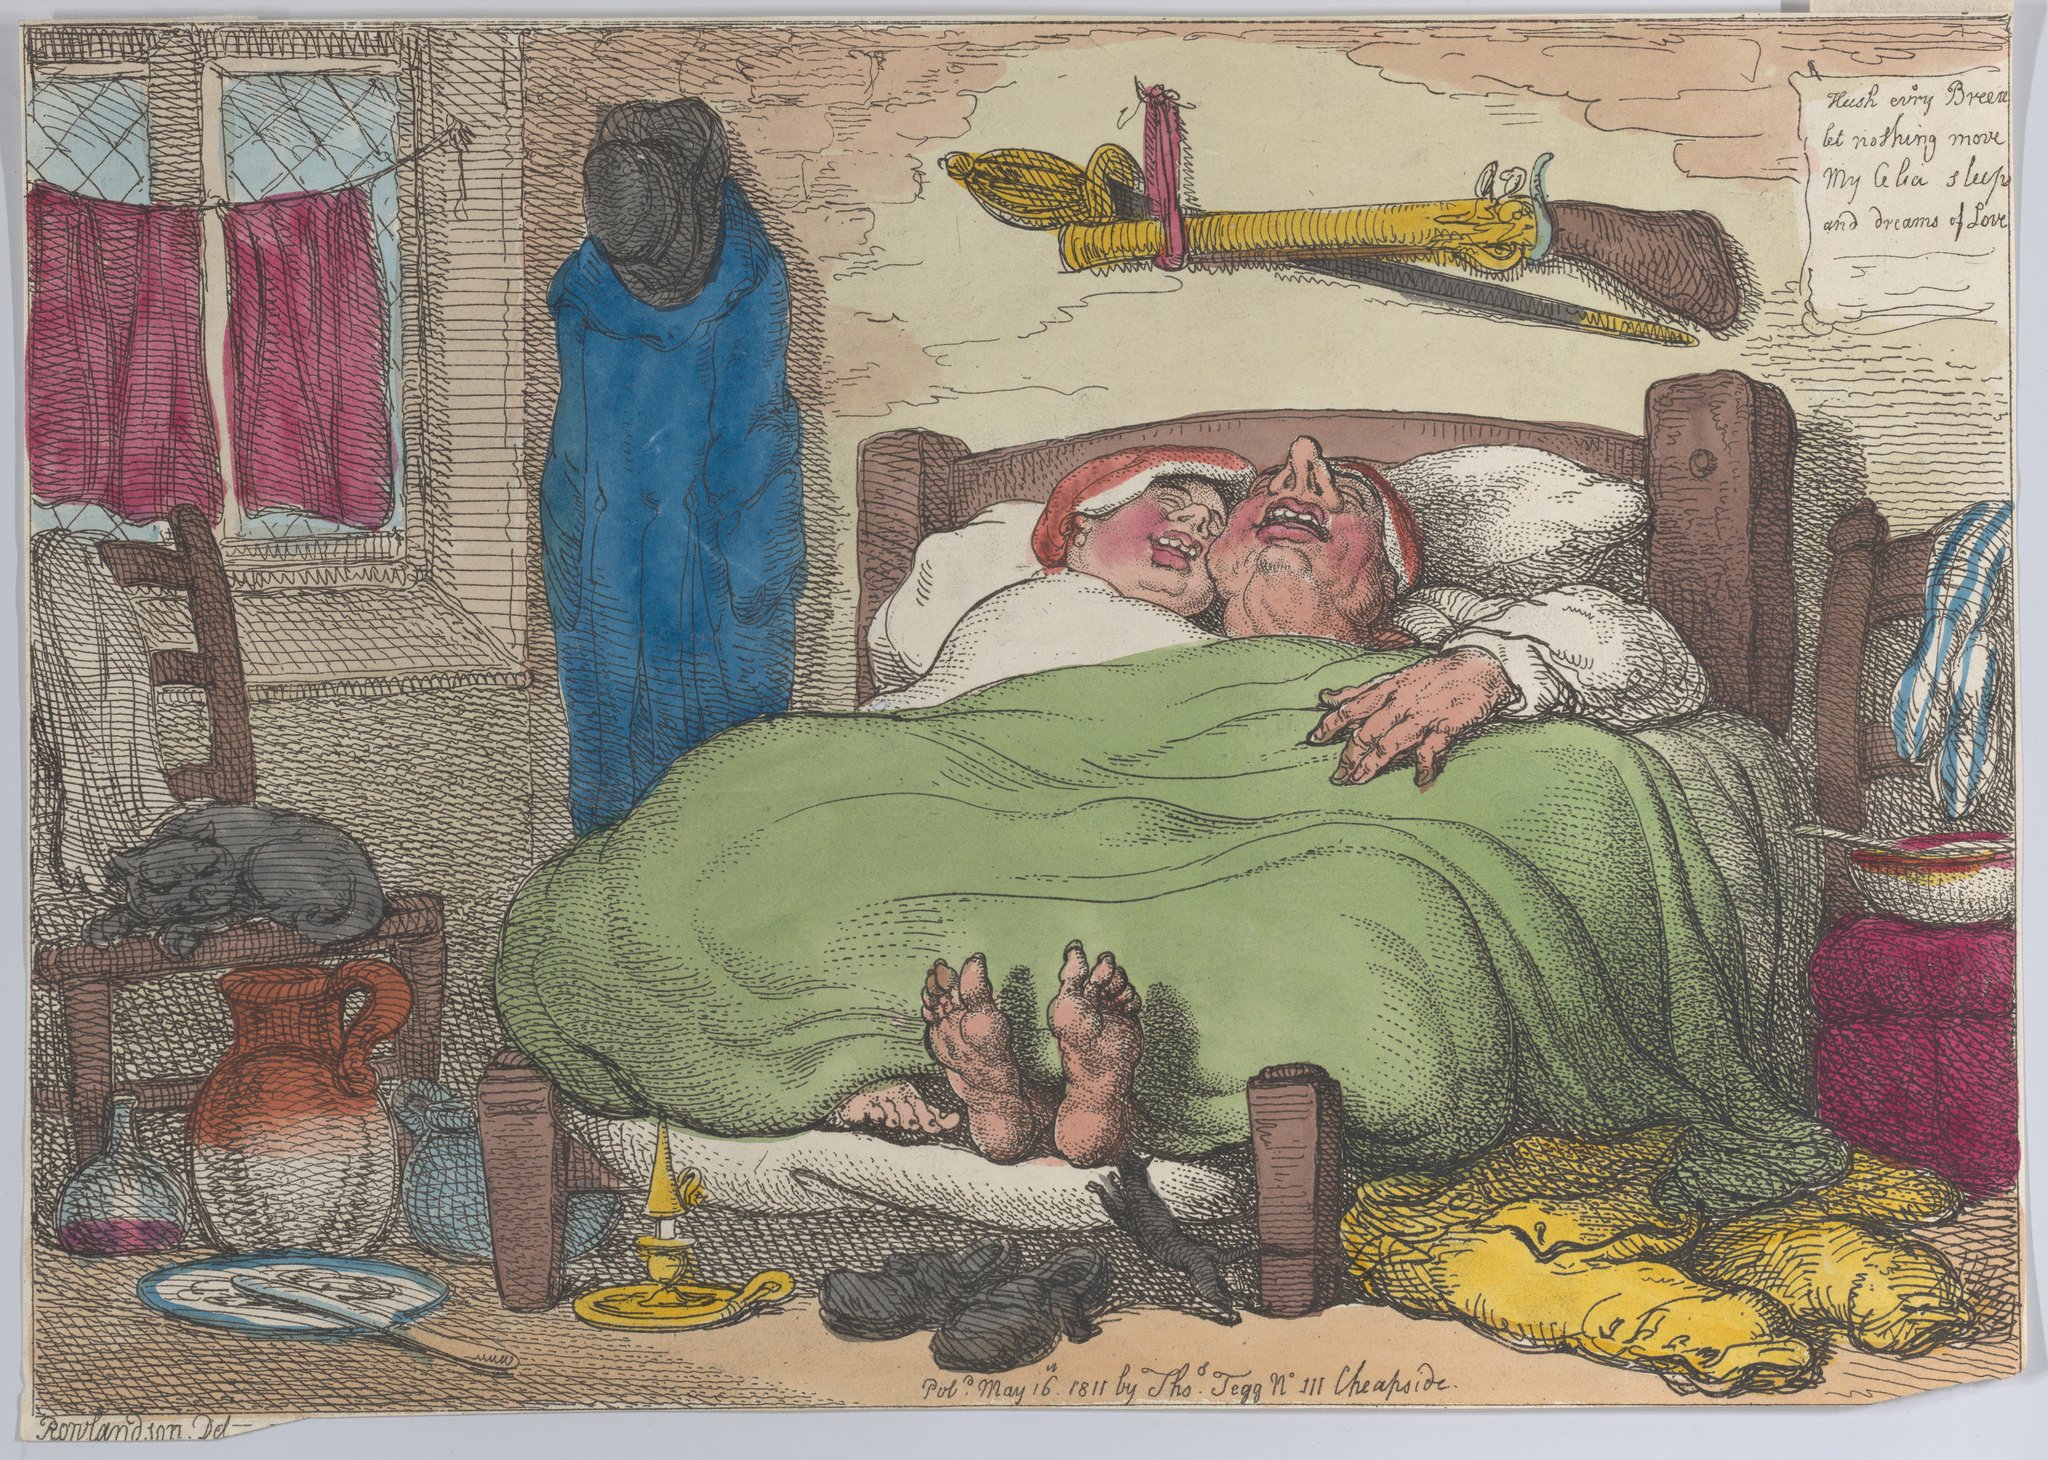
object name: print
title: The Bassoon with a French Horn Accompaniment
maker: thomas rowlandson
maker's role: artist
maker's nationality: british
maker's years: 1757-1827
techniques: etching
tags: satire,sleeping,men,women,cats,beds